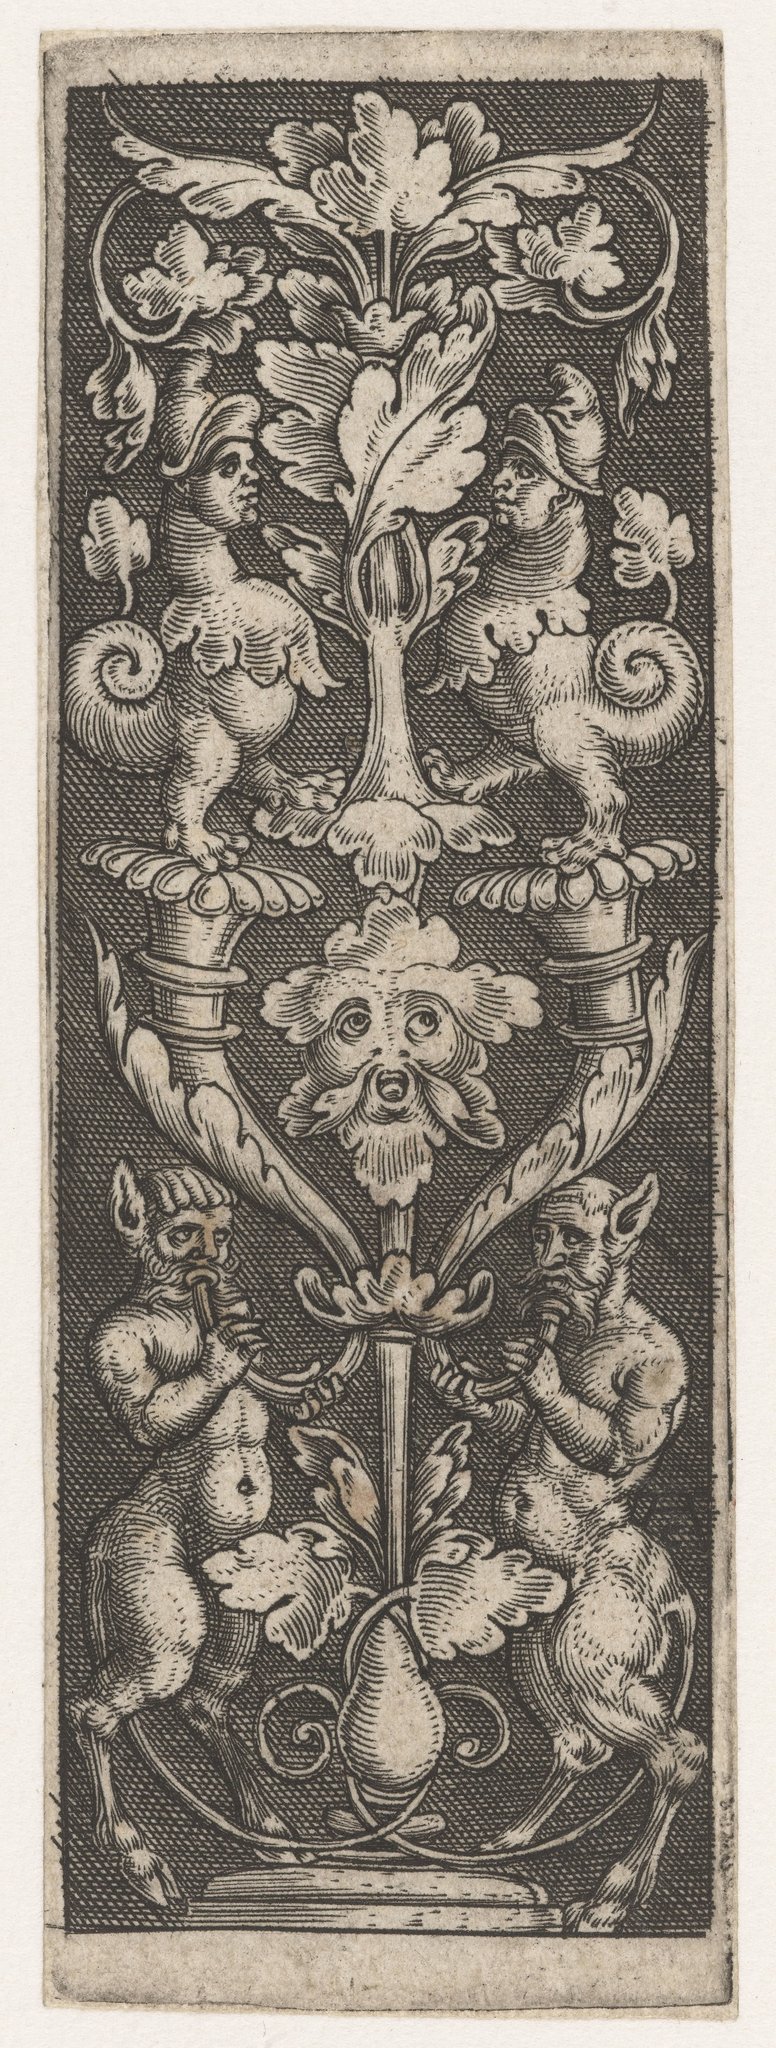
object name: ornament print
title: Ornament met twee saters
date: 1520-1562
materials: paper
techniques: engraving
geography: low countries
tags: ornament ~ candelabrum, satyr(s) (in general)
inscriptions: collector's mark: Lugt 240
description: Aan voet van kandelaber met bladranken twee saters. Zij blazen op hoorn, waarop twee fantasiewezen met muts zitten.